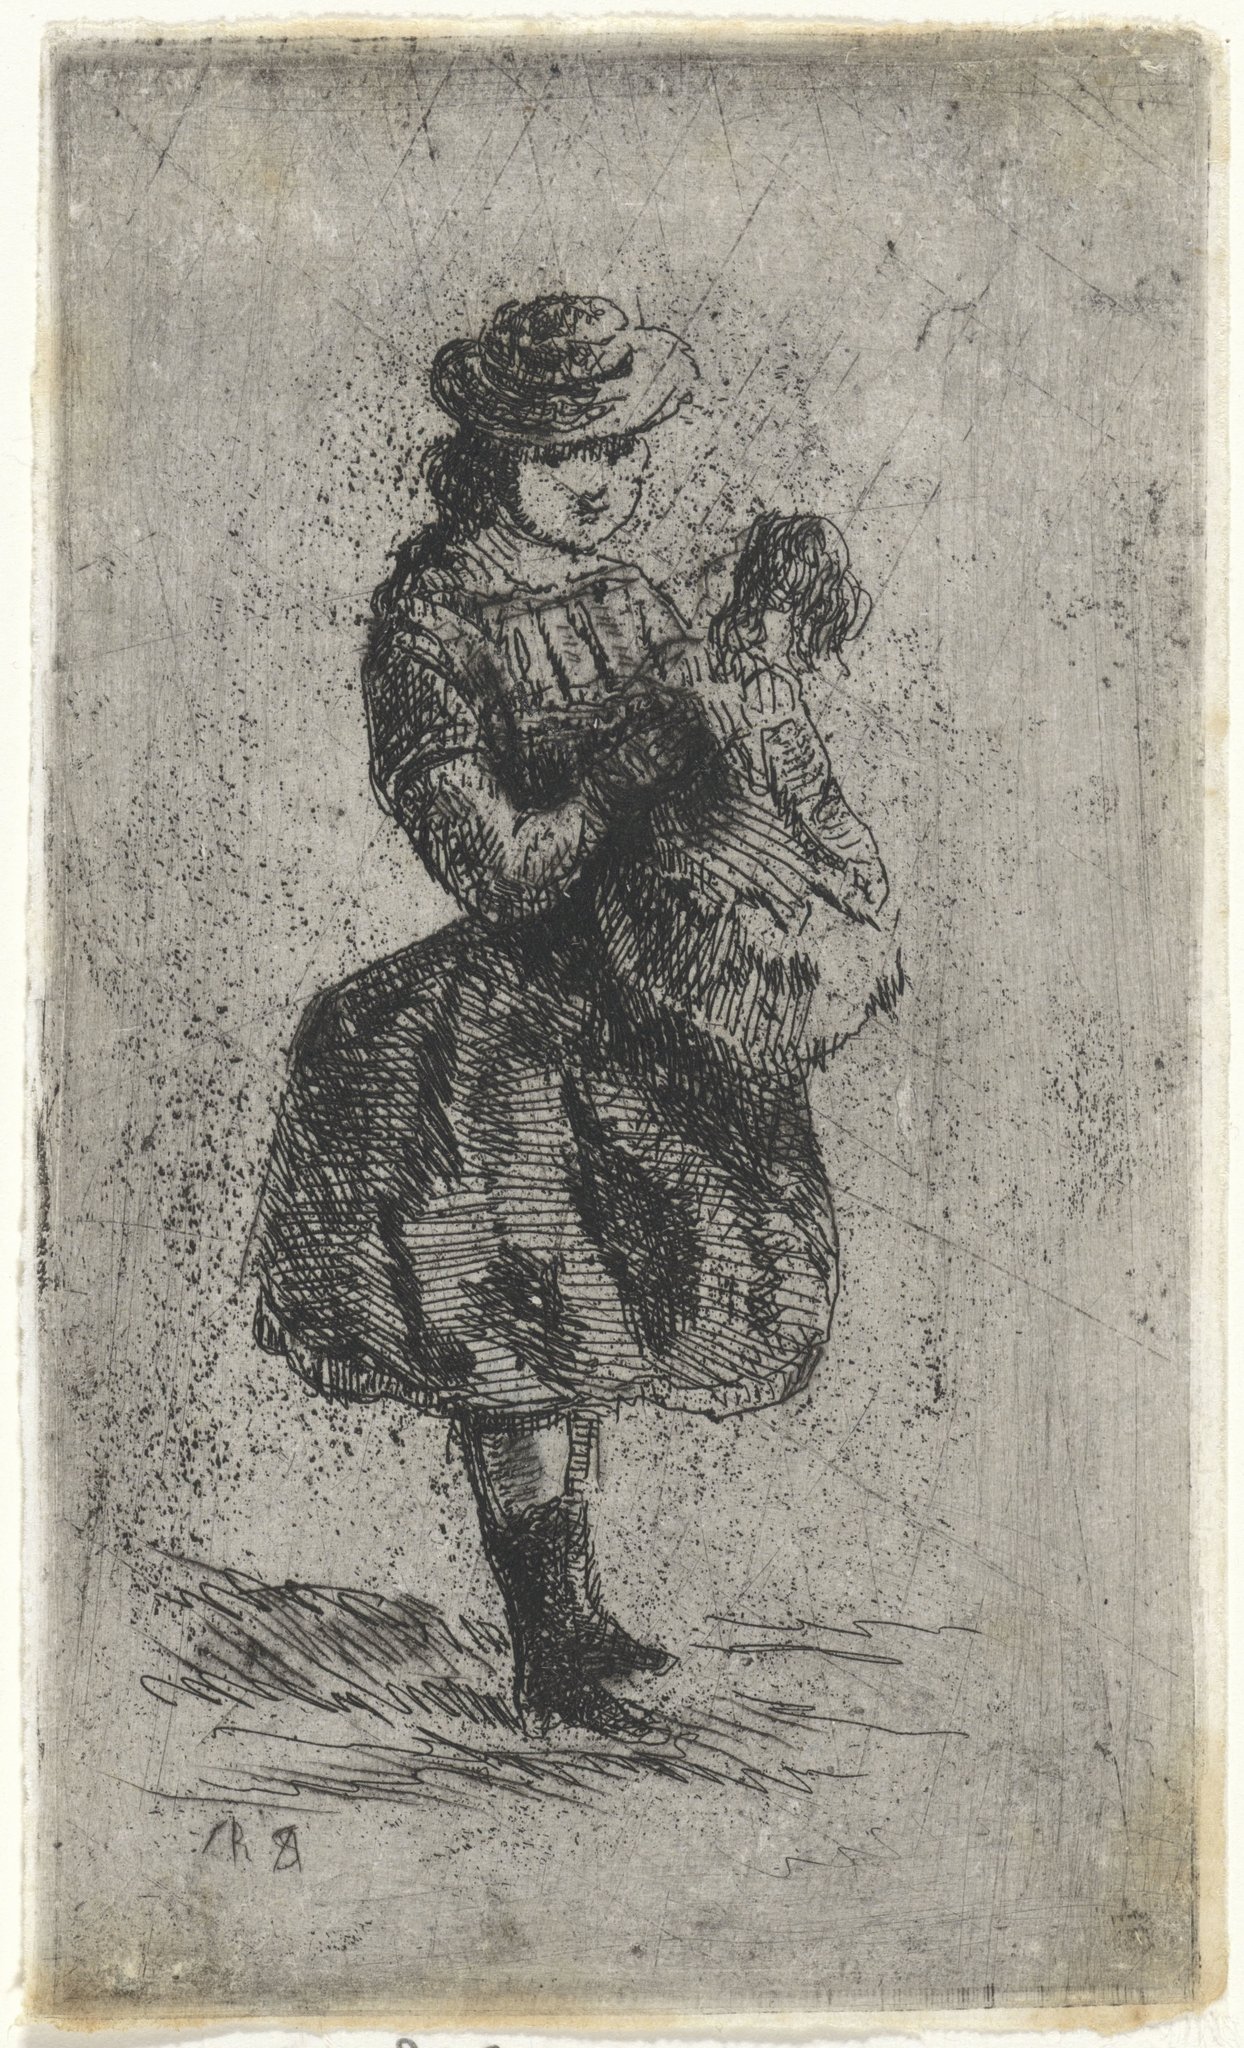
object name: print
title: Meisje met een pop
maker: arnoud schaepkens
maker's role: print maker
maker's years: 1816-1904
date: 1831-1904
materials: paper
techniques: drypoint, etching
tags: (playing with) dolls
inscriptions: collector's mark: Lugt 2228